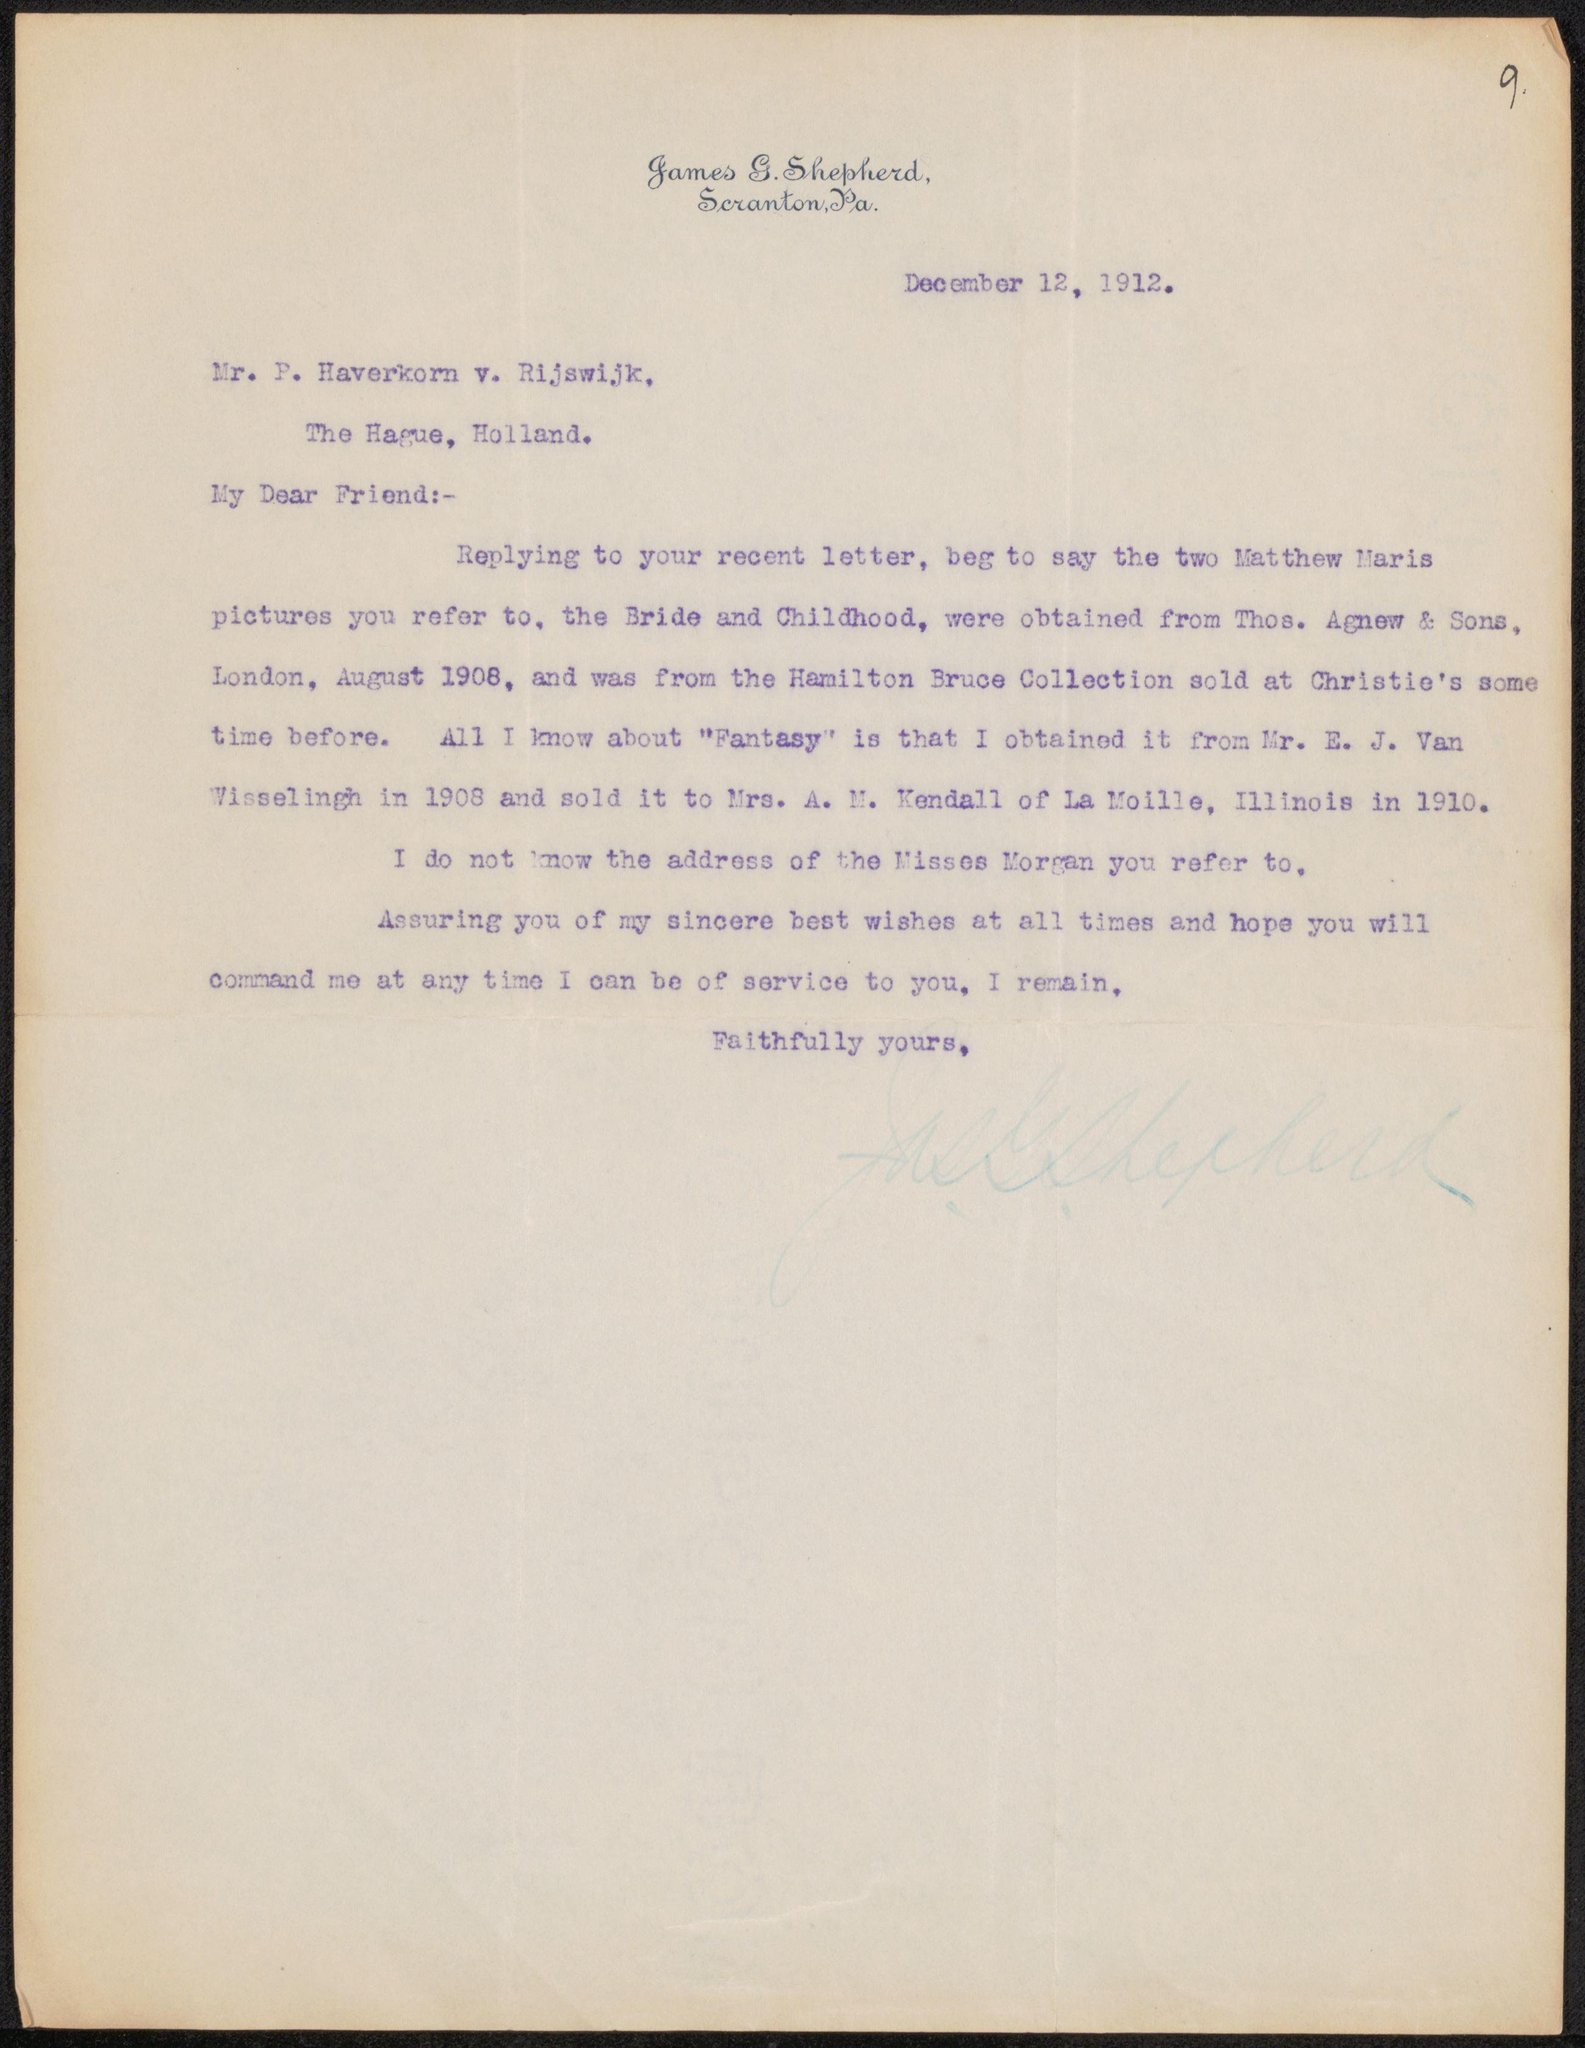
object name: letter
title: Brief aan Pieter Haverkorn van Rijsewijk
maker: james g. shepherd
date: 1912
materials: ink, paper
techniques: pen, printing, typewriting, writing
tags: london, painter, print maker, draughtsman, matthijs maris, pieter haverkorn van rijsewijk, elbert jan van wisselingh, art trade, art shop, painting (including book-illumination, miniature-painting), art collecting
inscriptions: watermark